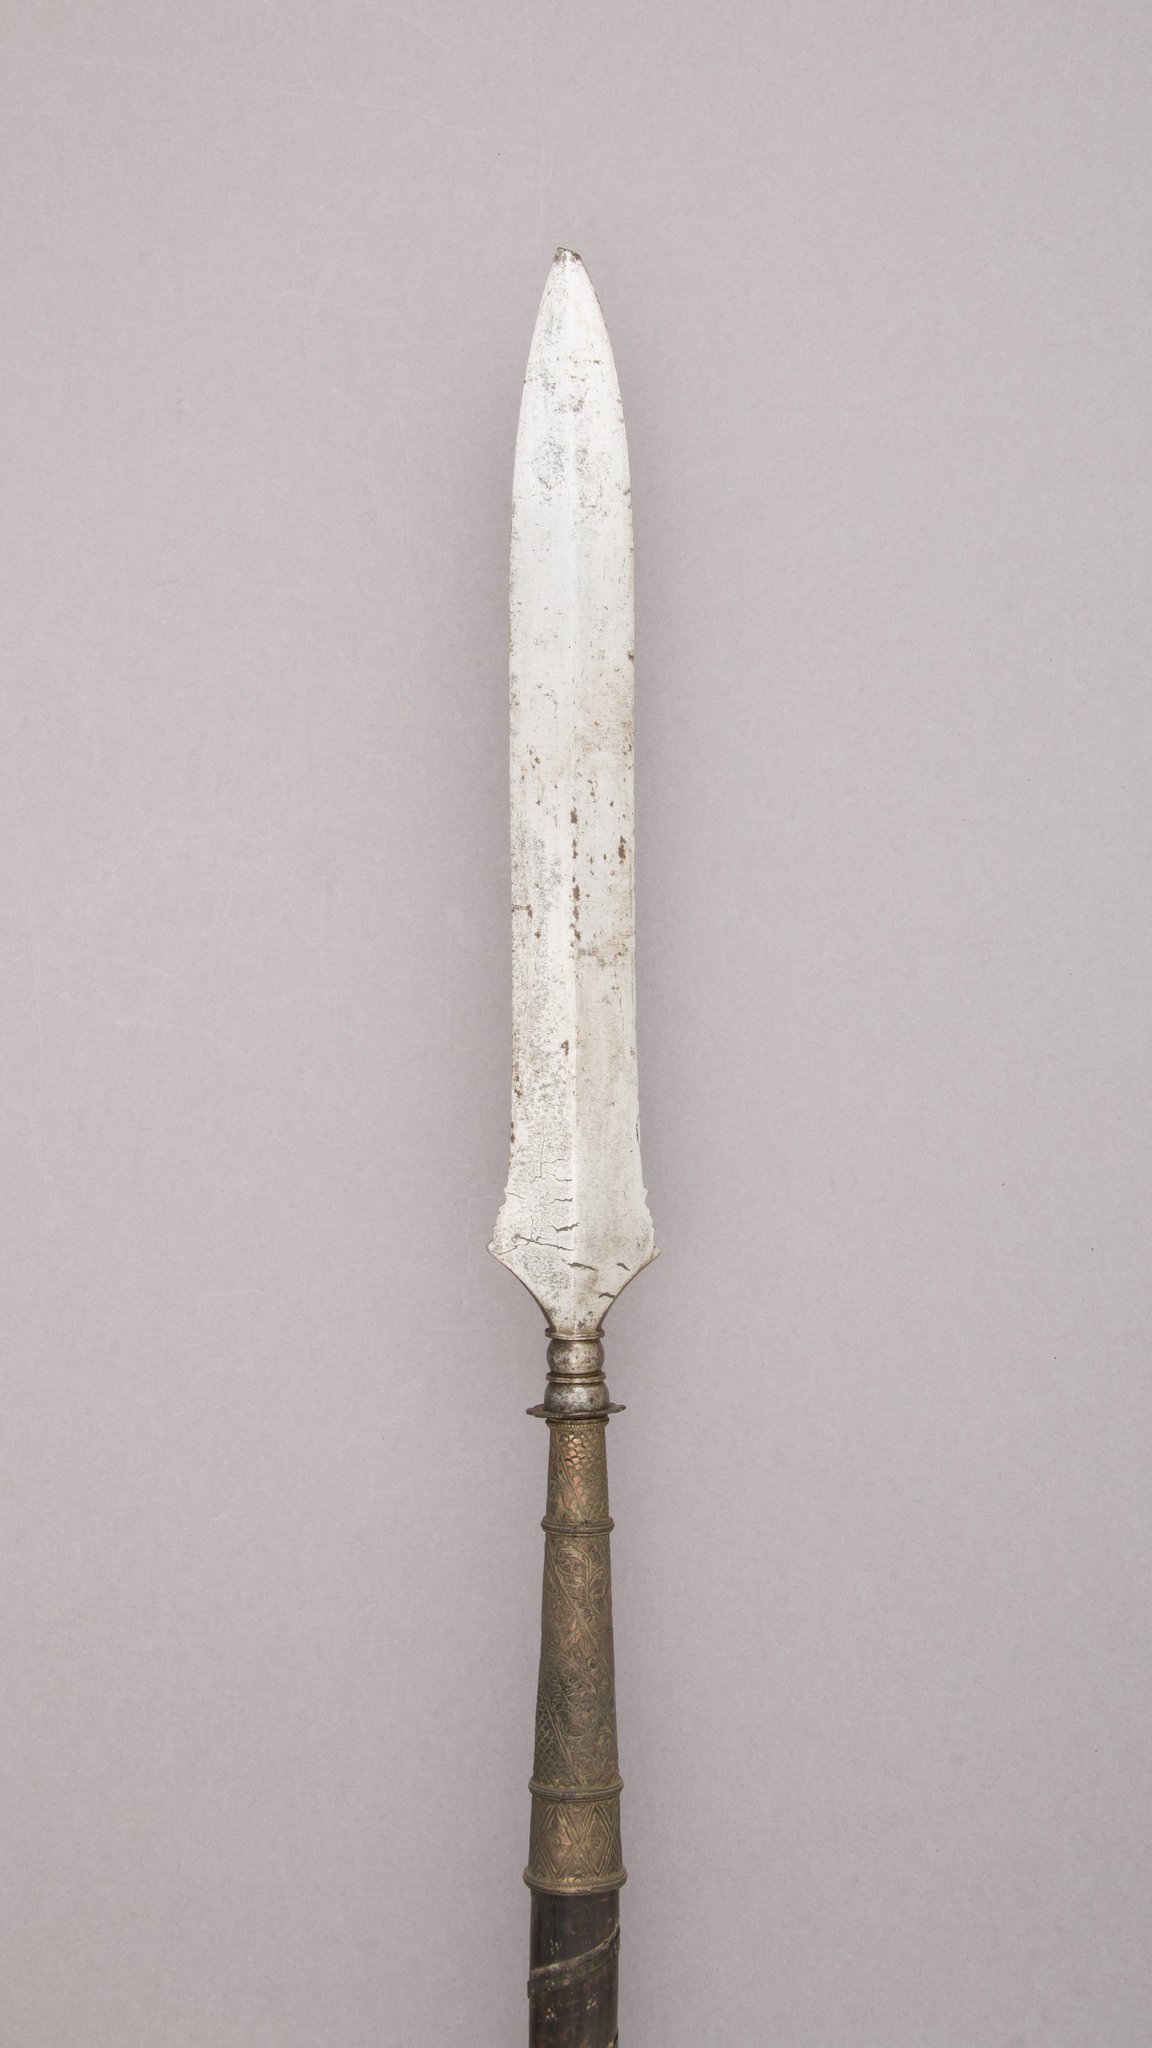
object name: spear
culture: javanese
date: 1501-1900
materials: silver, steel, wood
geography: indonesia